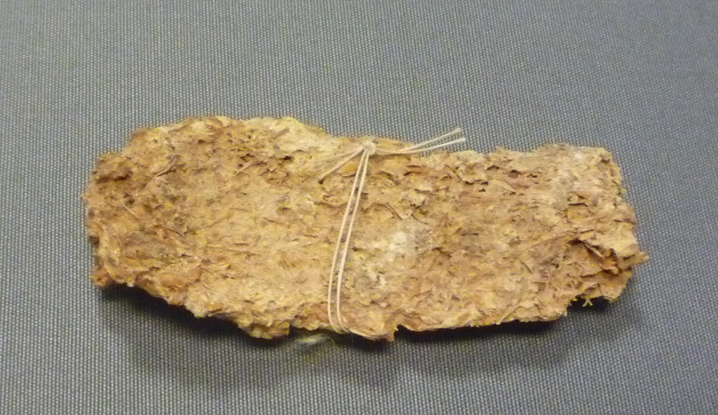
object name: model bread loaf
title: Model Bread Loaf from the Foundation Deposit for Hatshepsut's Tomb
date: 1479-1458 BCE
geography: egypt